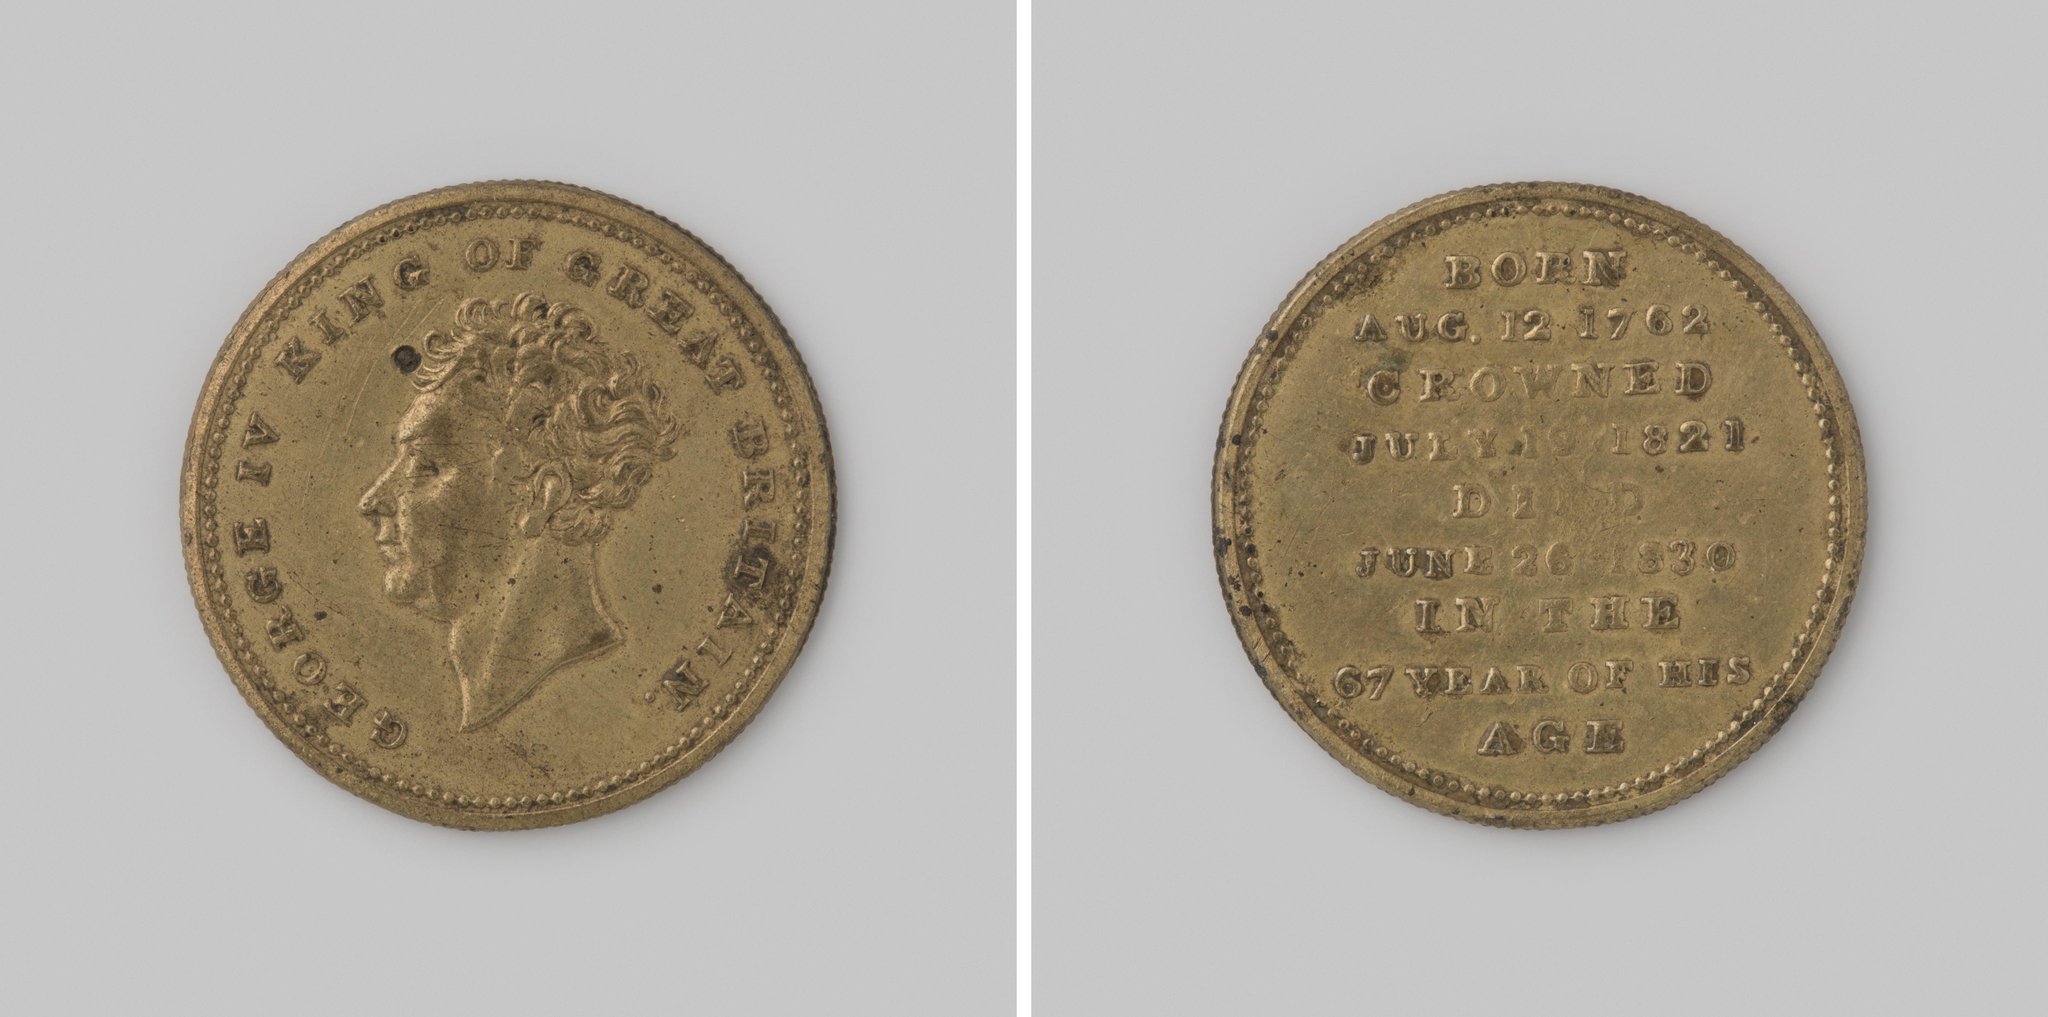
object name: history medal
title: Overlijden van Koning George IV van Engeland 1830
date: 1830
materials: brass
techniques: striking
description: Messing penning, op de voorzijde het portret van George IV naar links met omschrift, op de keerzijde negen regels tekst, kartelrand.